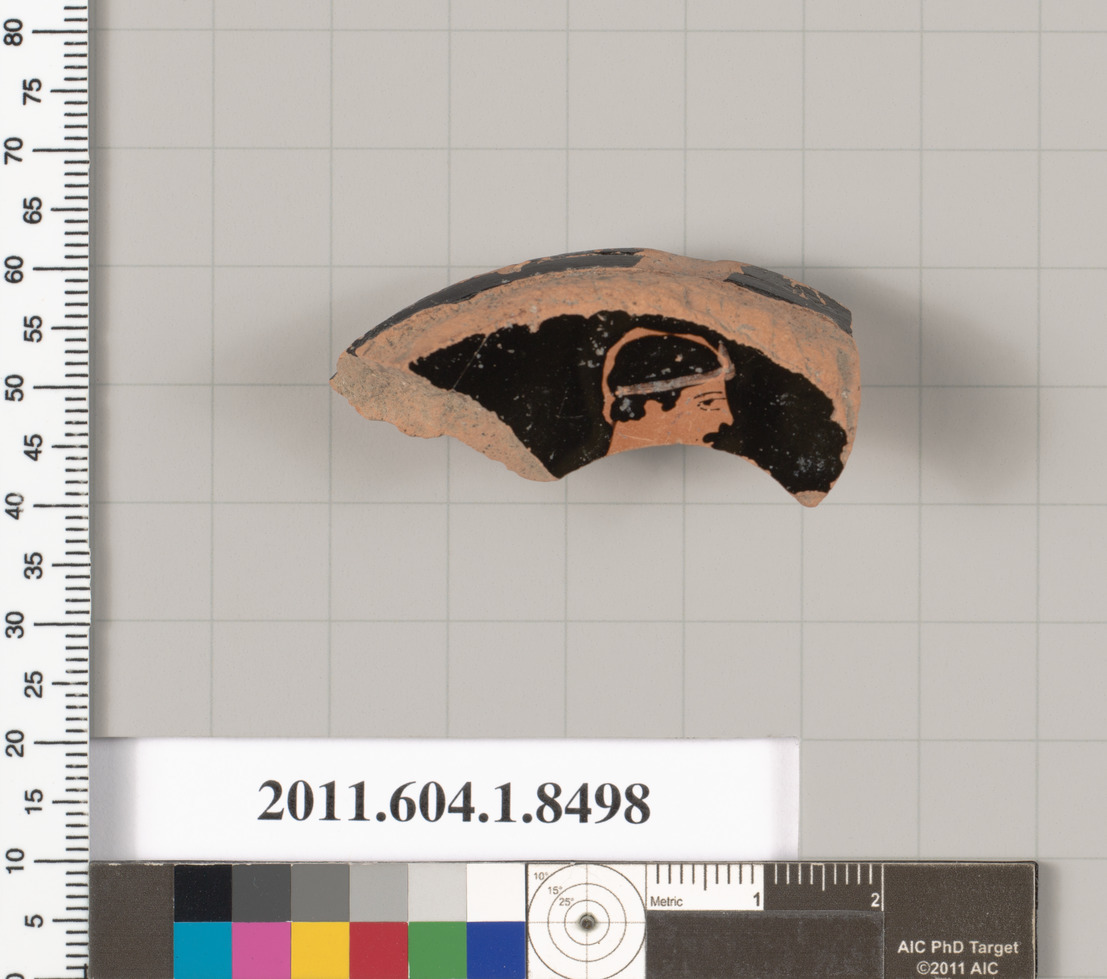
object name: kylix fragment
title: Terracotta fragment of a stemless kylix (drinking cup)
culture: greek, attic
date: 460-450 BCE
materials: terracotta